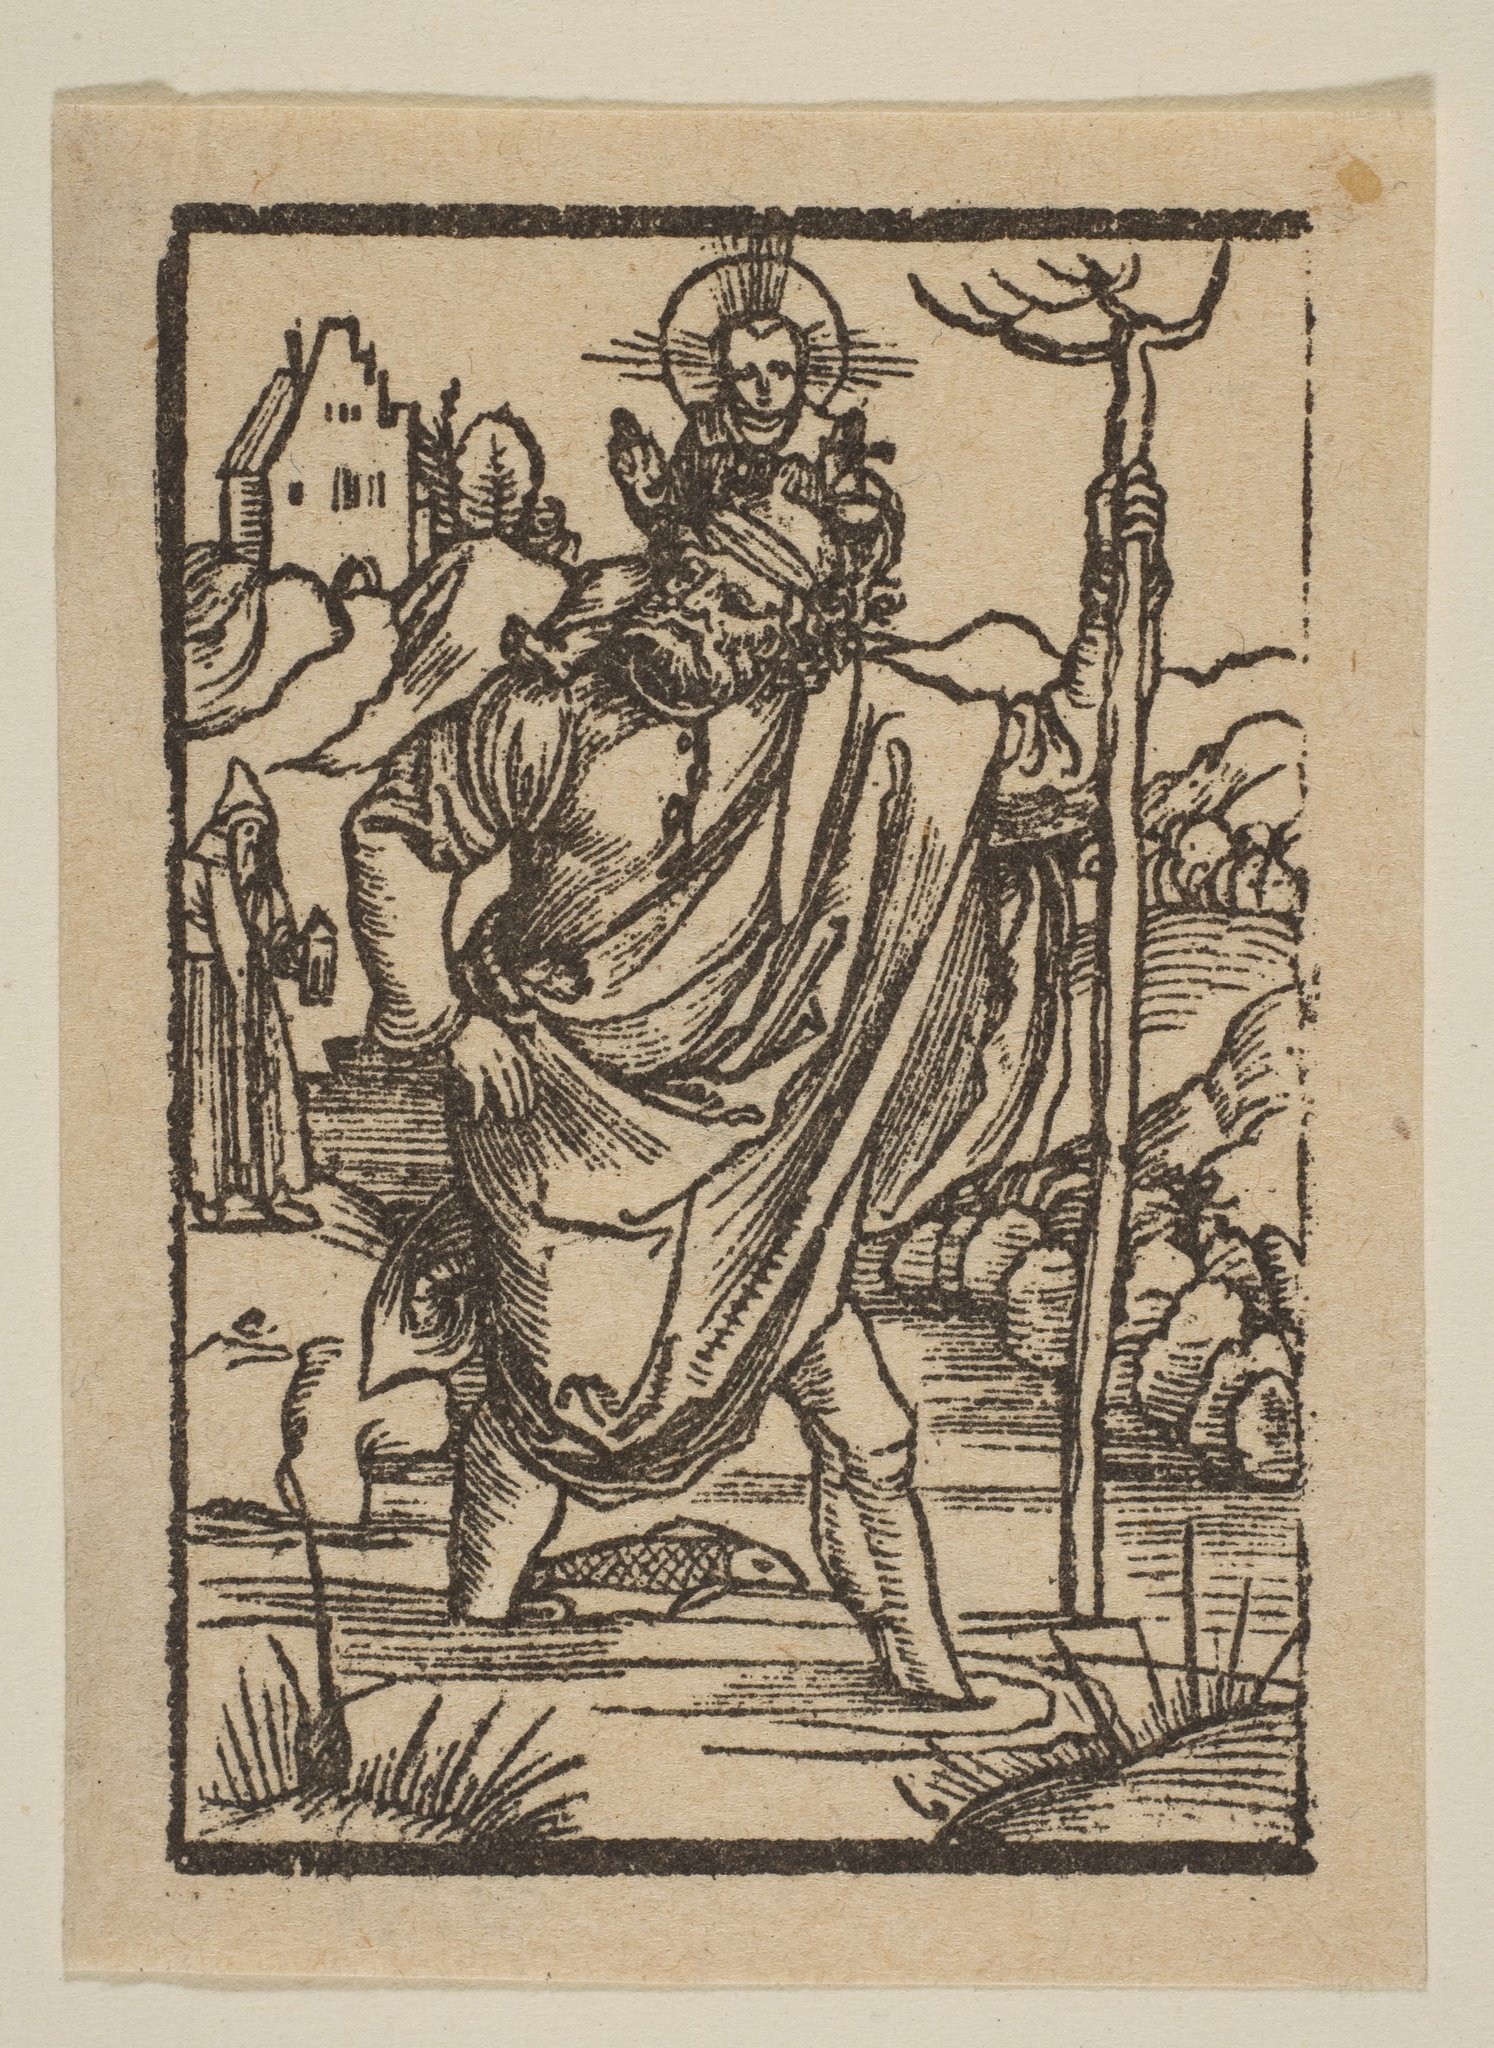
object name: print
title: Saint Christopher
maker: albrecht dürer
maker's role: artist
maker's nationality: german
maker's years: 1471-1528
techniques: woodcut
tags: saint christopher,jesus